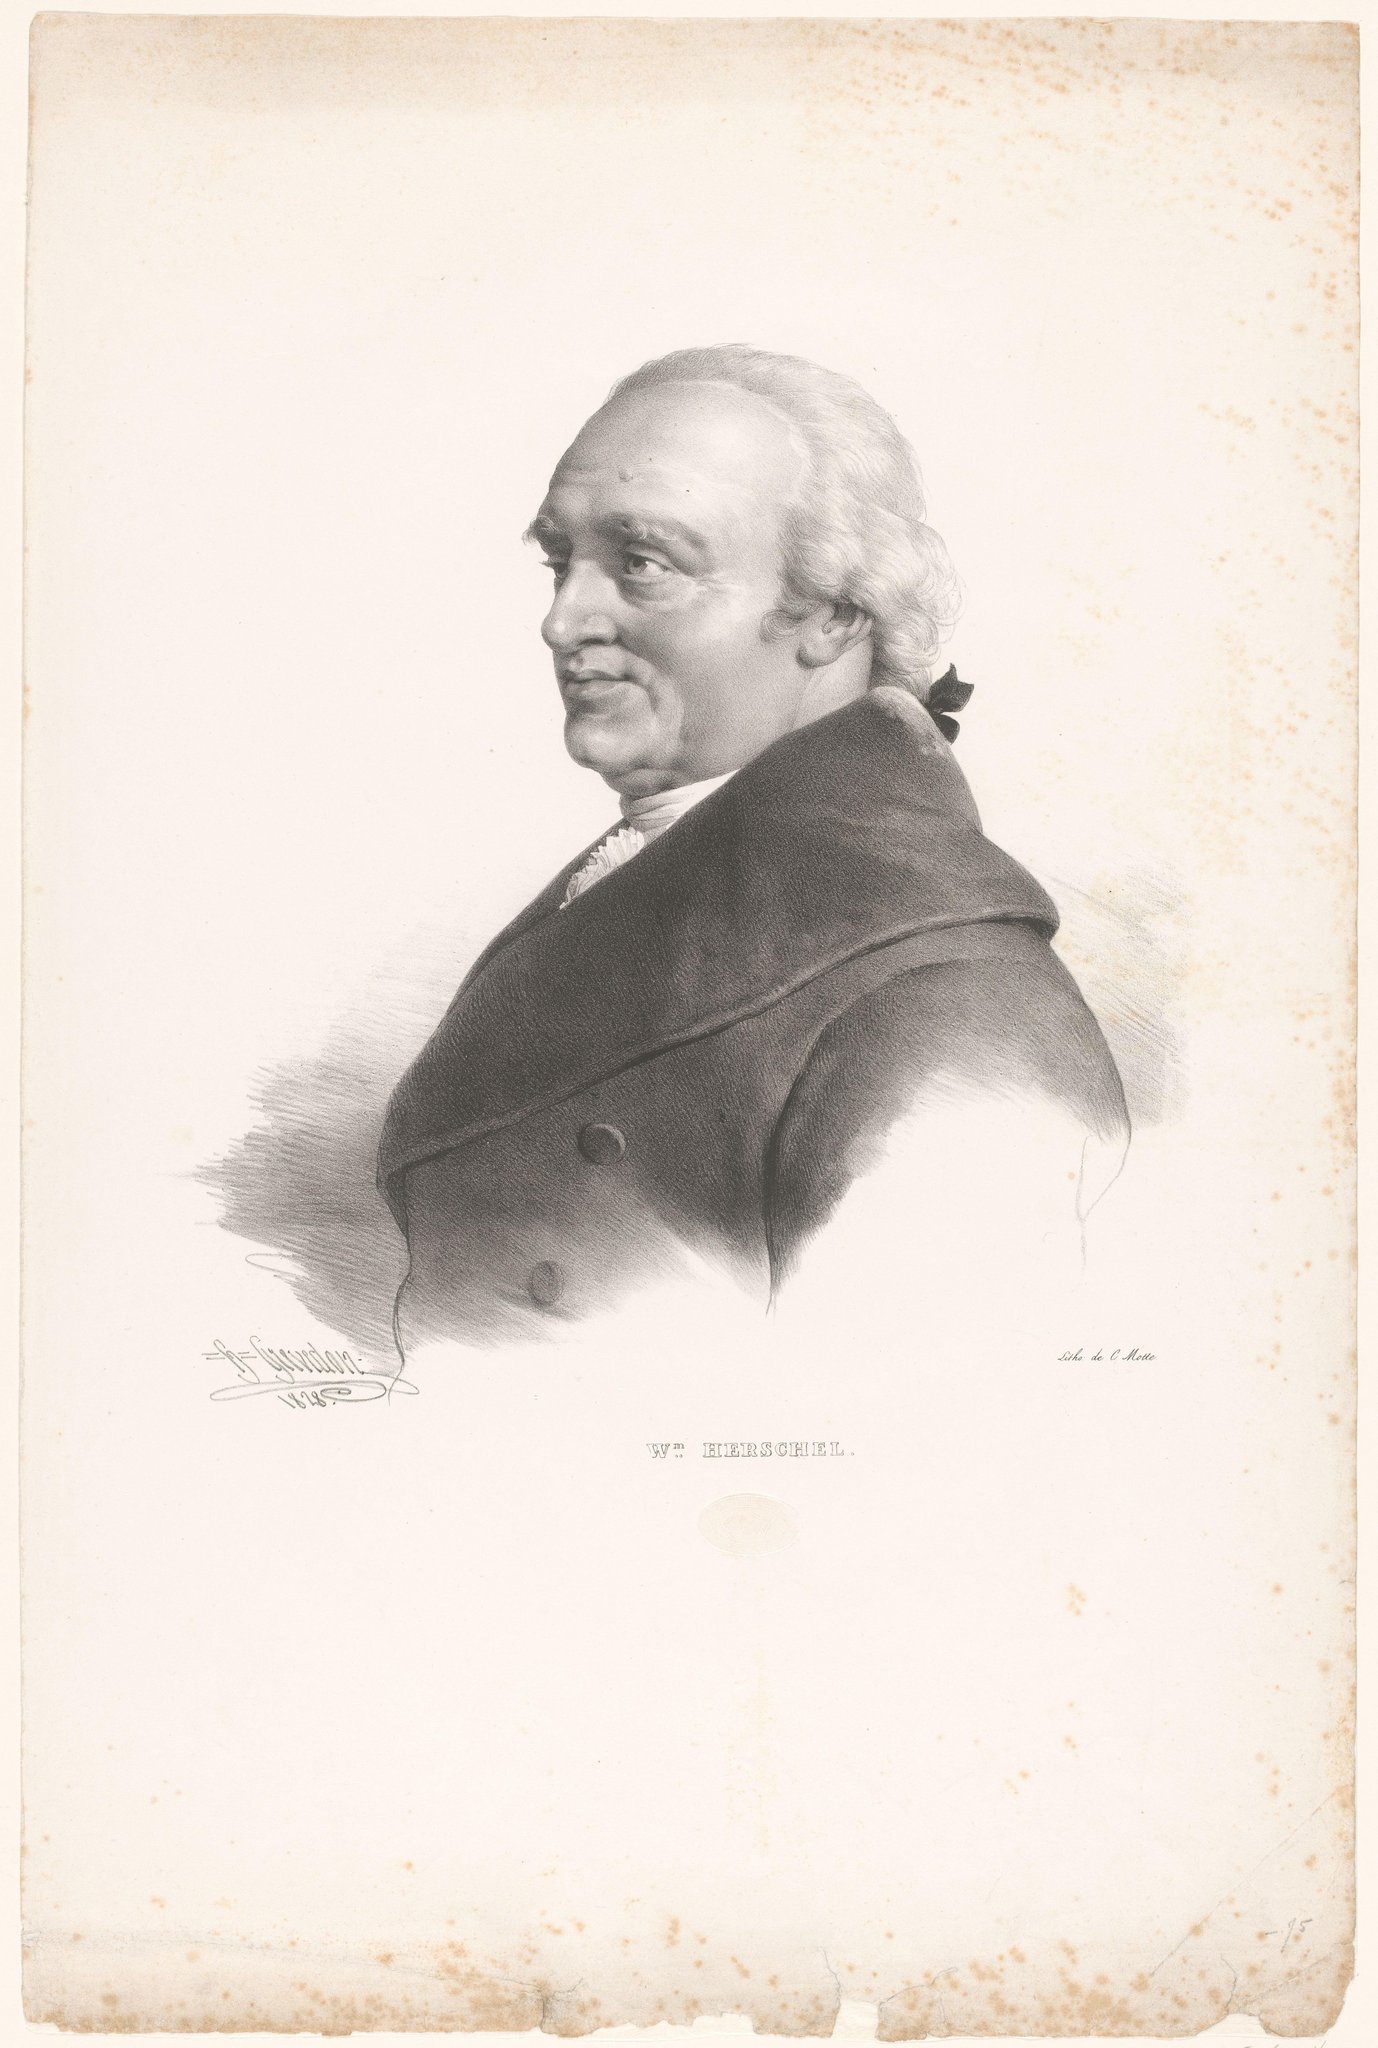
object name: print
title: Wm. Herschel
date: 1828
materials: paper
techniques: lithograph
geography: paris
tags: england, historical persons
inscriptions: check stamp: Lugt 3996, collector's mark: Lugt 2228a